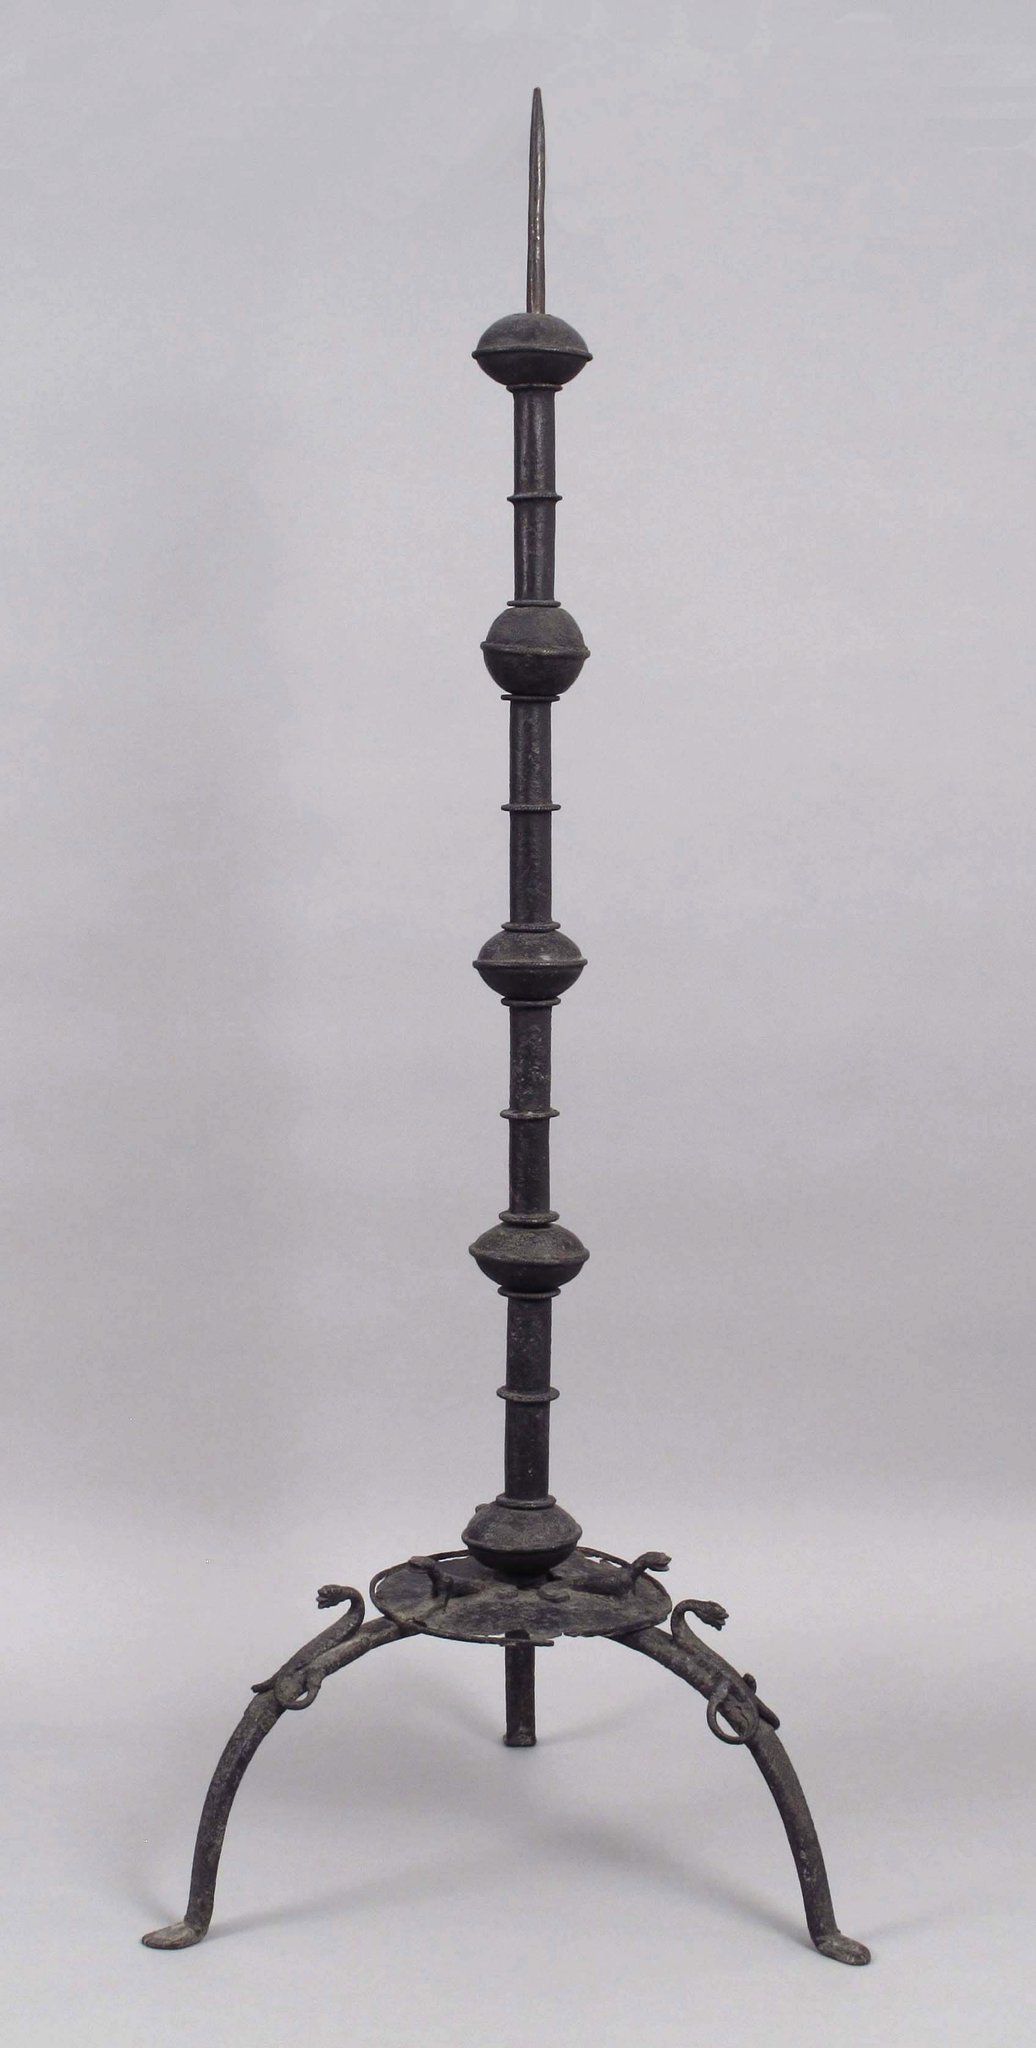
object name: candlestick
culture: french or italian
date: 1401-1500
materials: iron